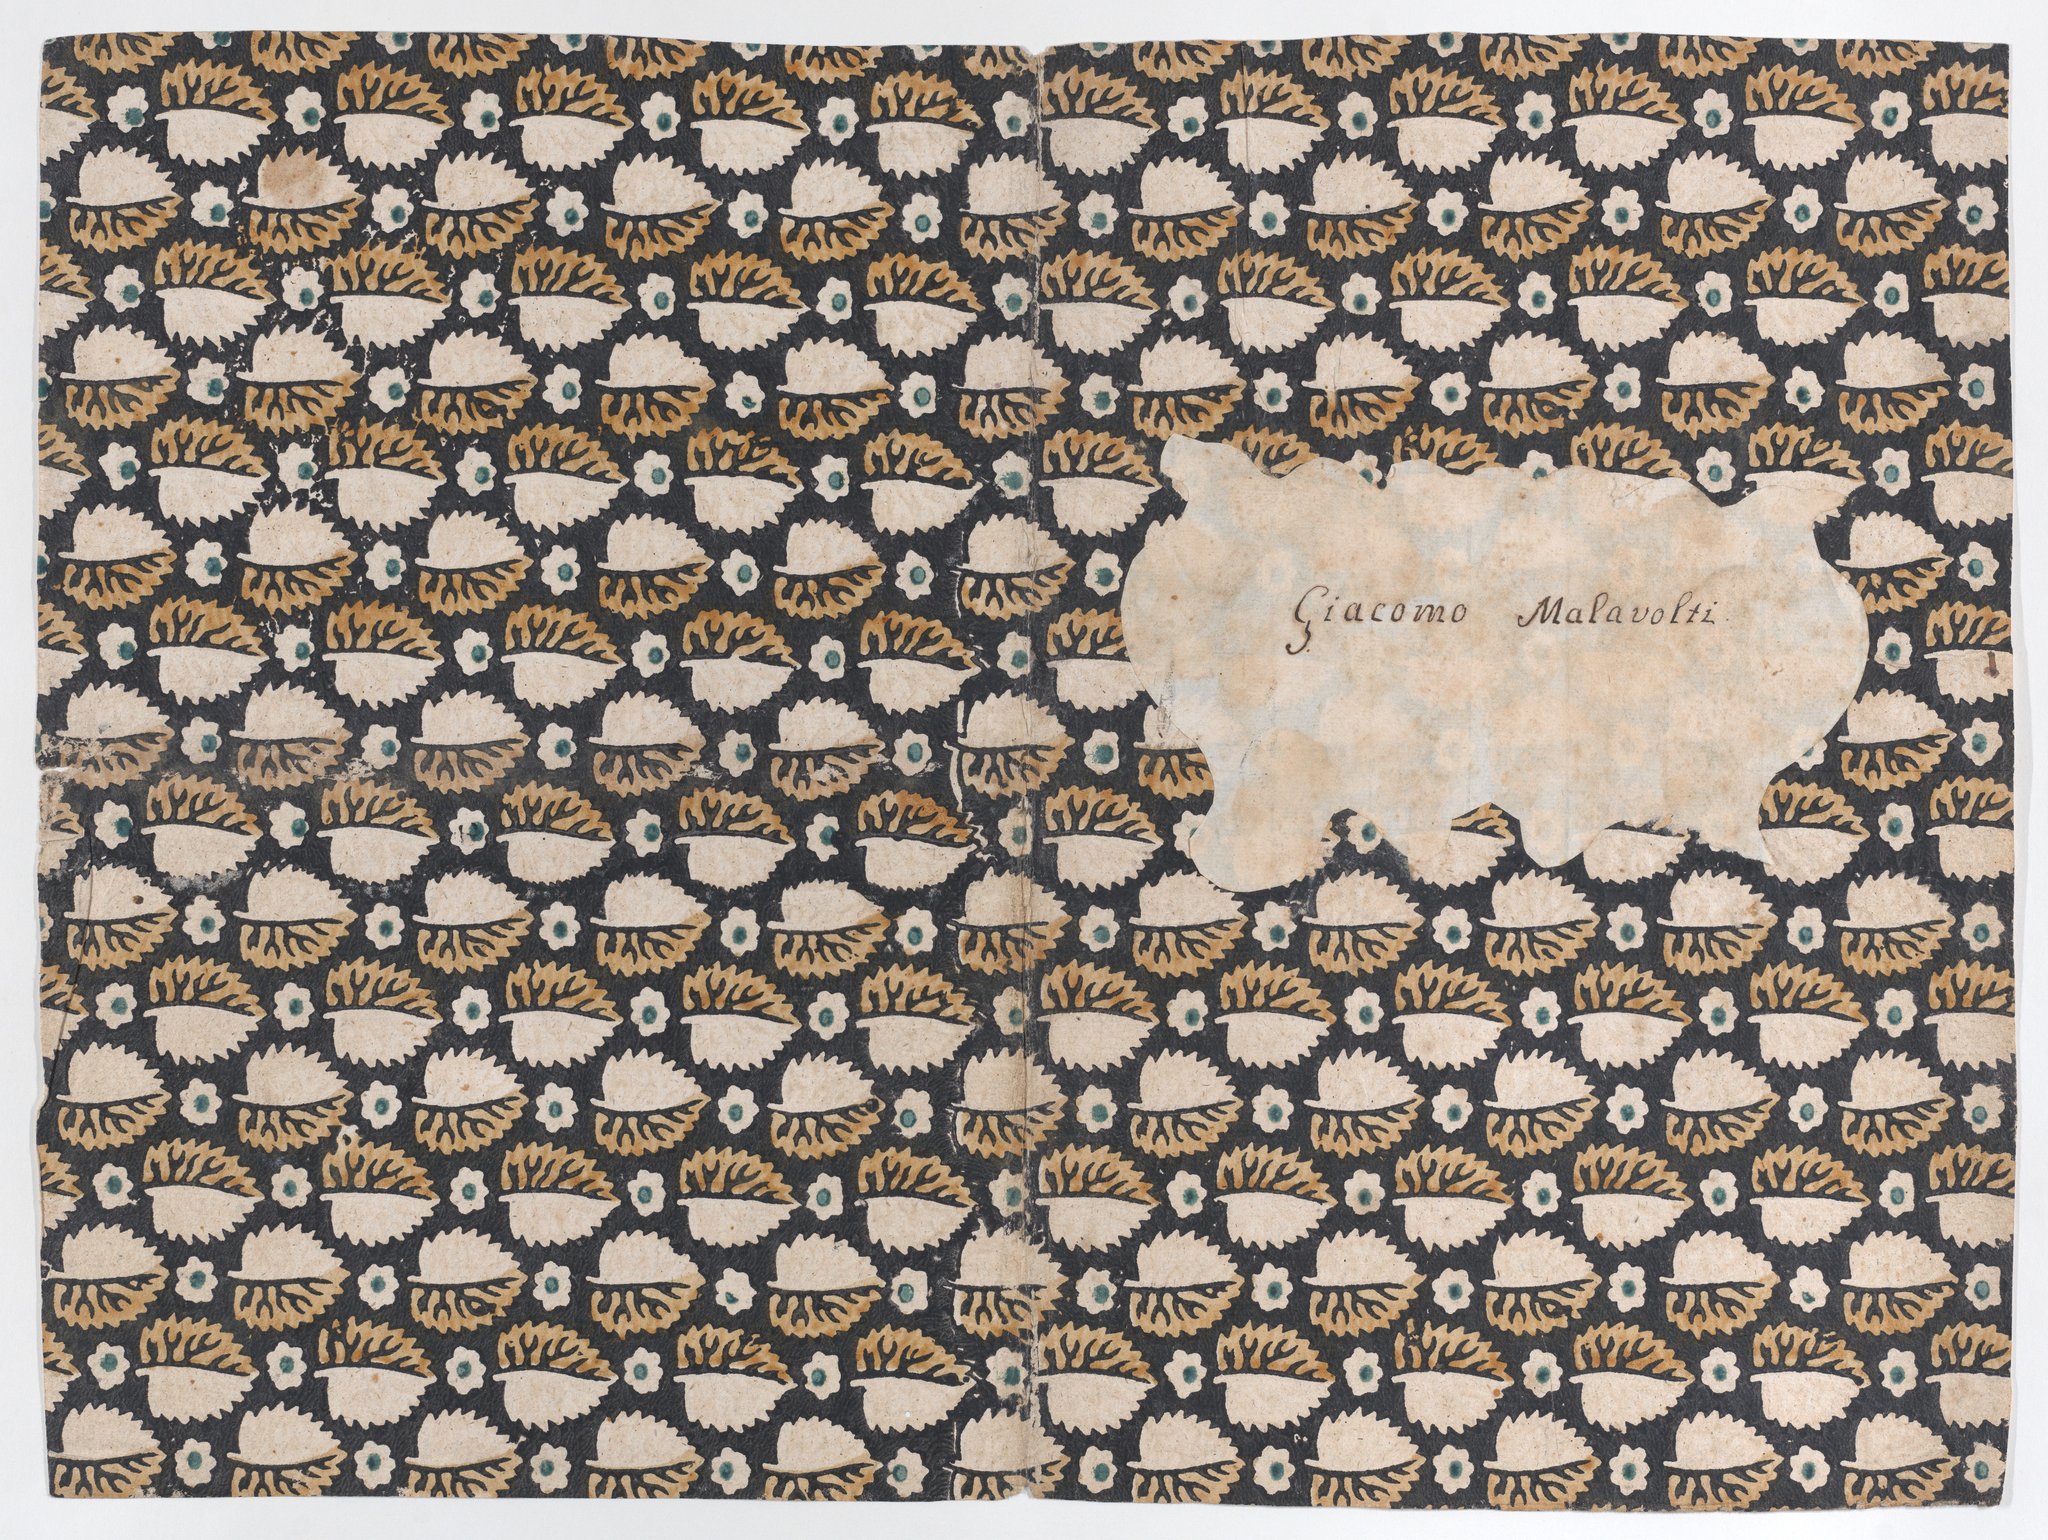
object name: print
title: Book cover with overall leaf pattern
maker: Anonymous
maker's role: artist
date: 1801-1900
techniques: relief print